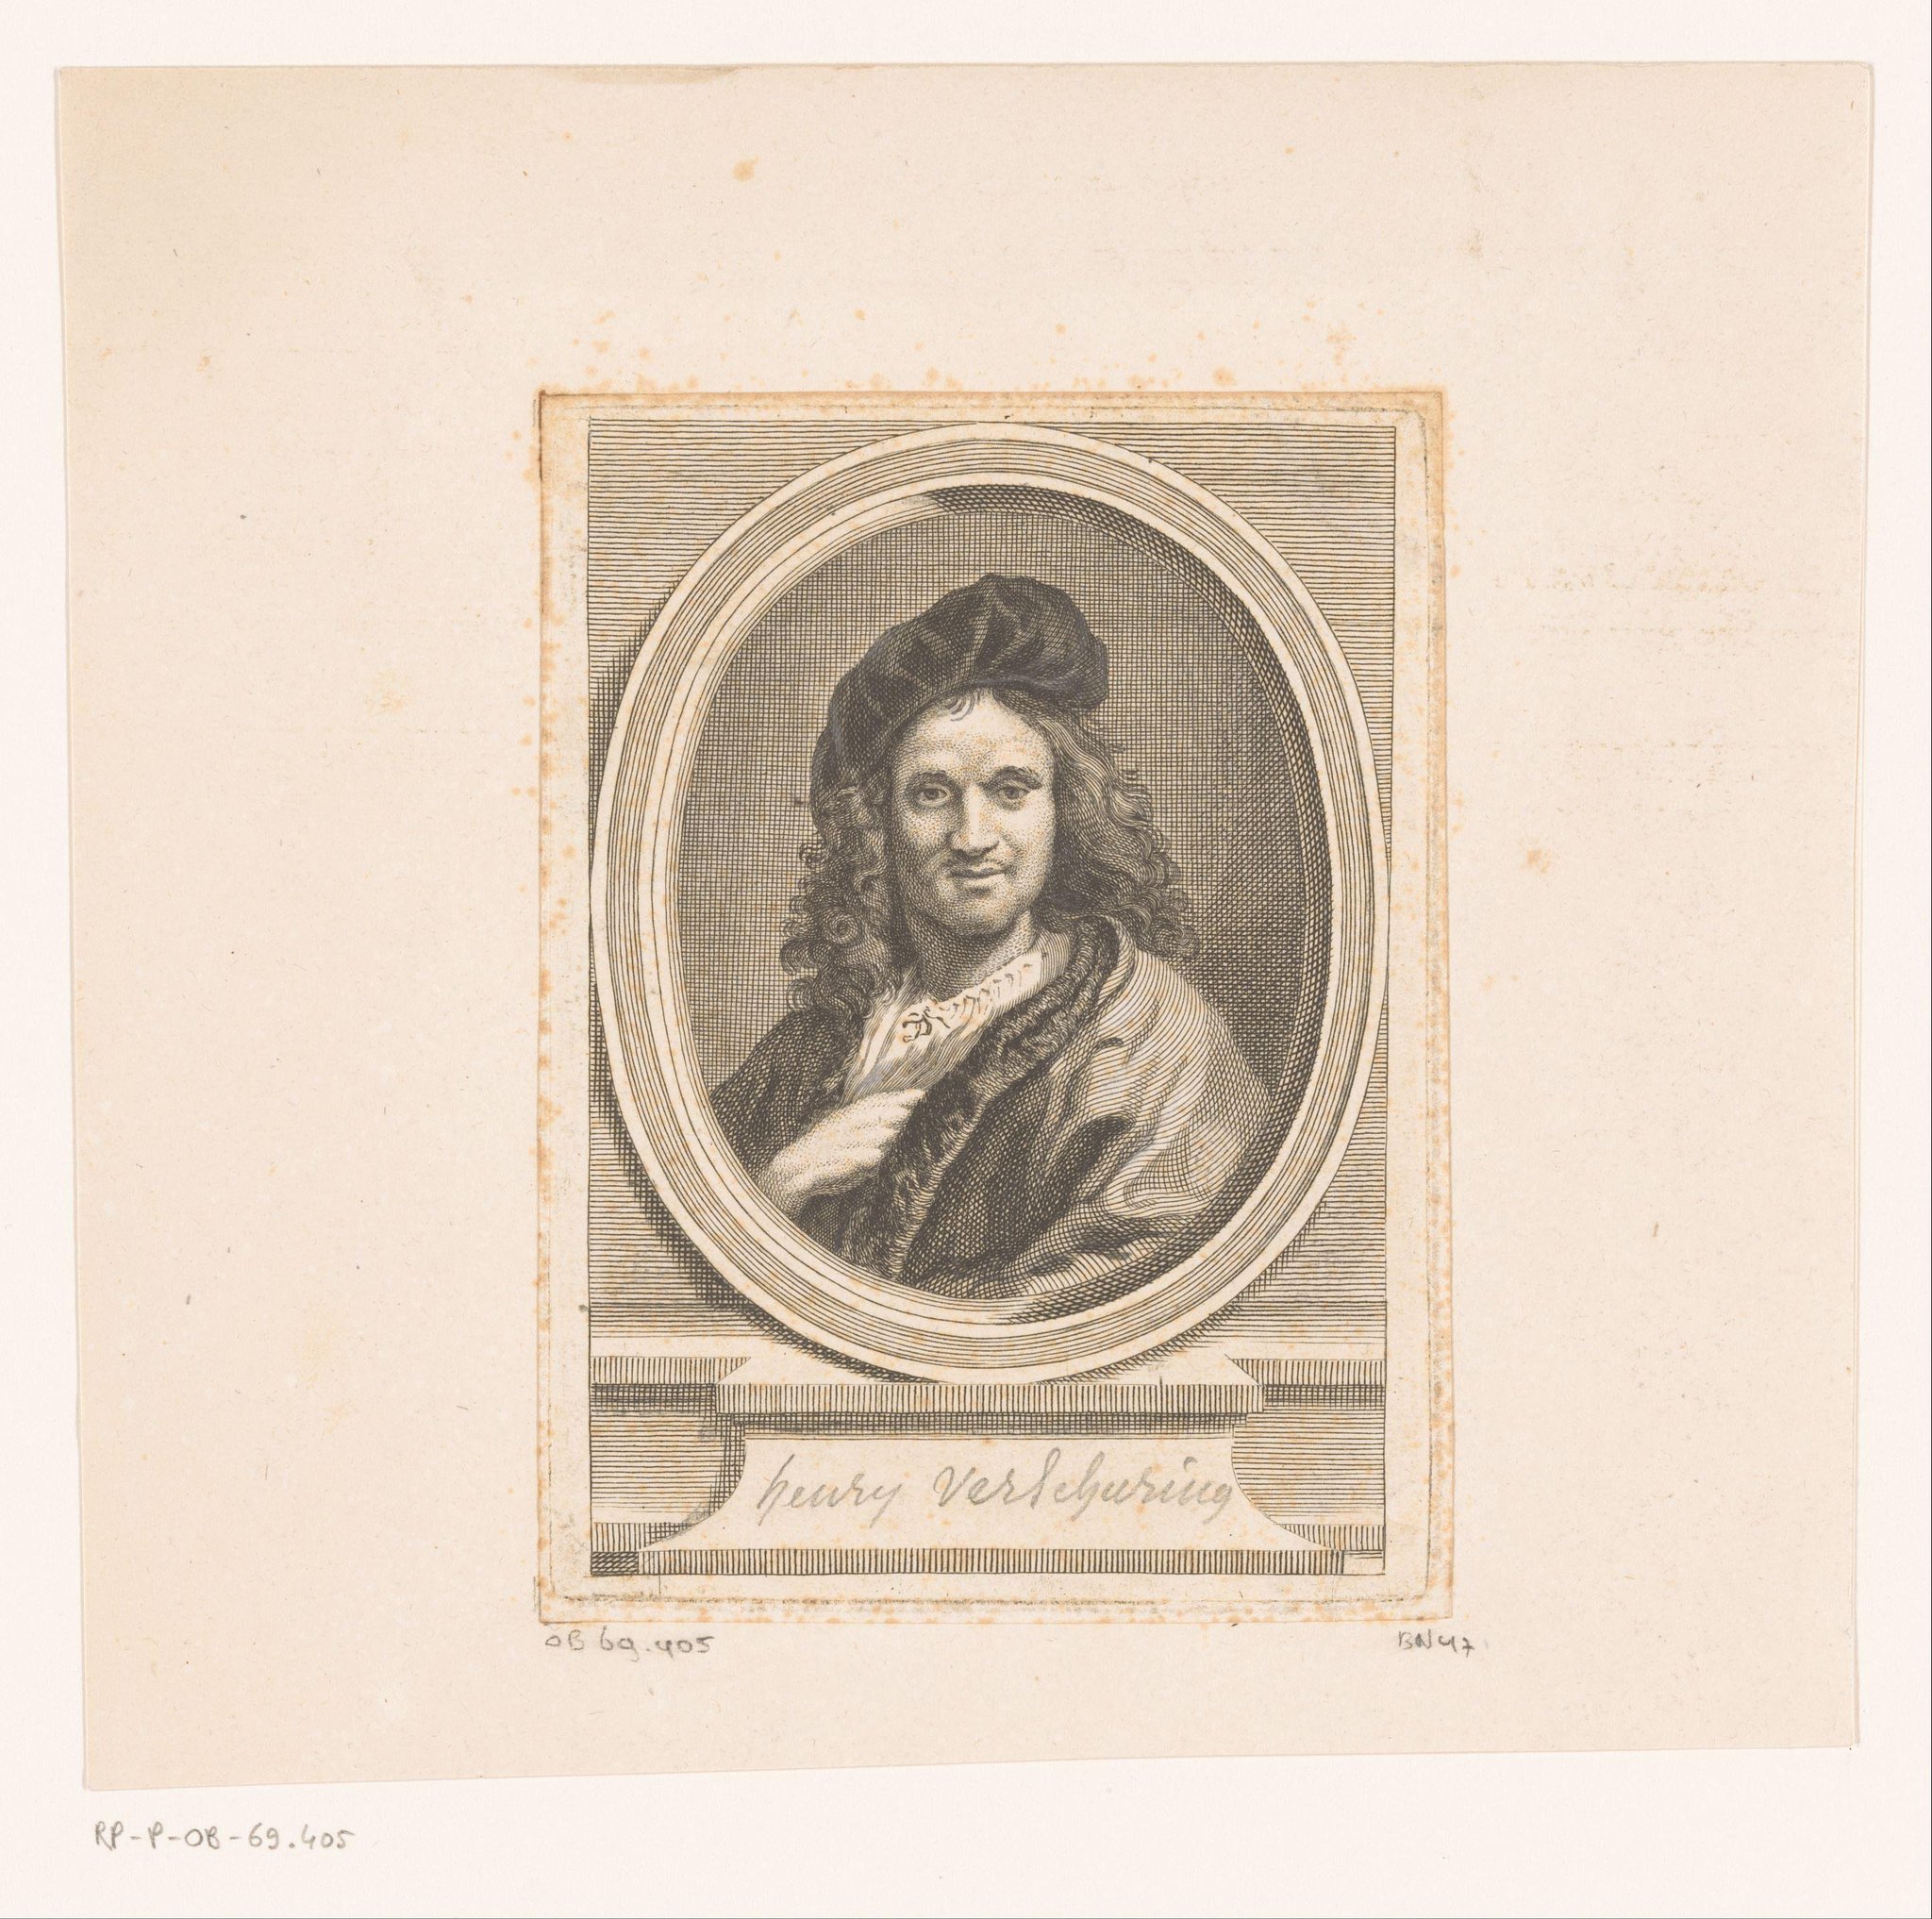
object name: print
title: Portret van Hendrik Verschuring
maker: bernard françois lépicié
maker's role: draughtsman, print maker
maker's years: 1698-1755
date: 1708-1755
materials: paper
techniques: engraving, etching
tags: dordrecht, hendrik verschuring, historical persons, portrait, self-portrait of painter